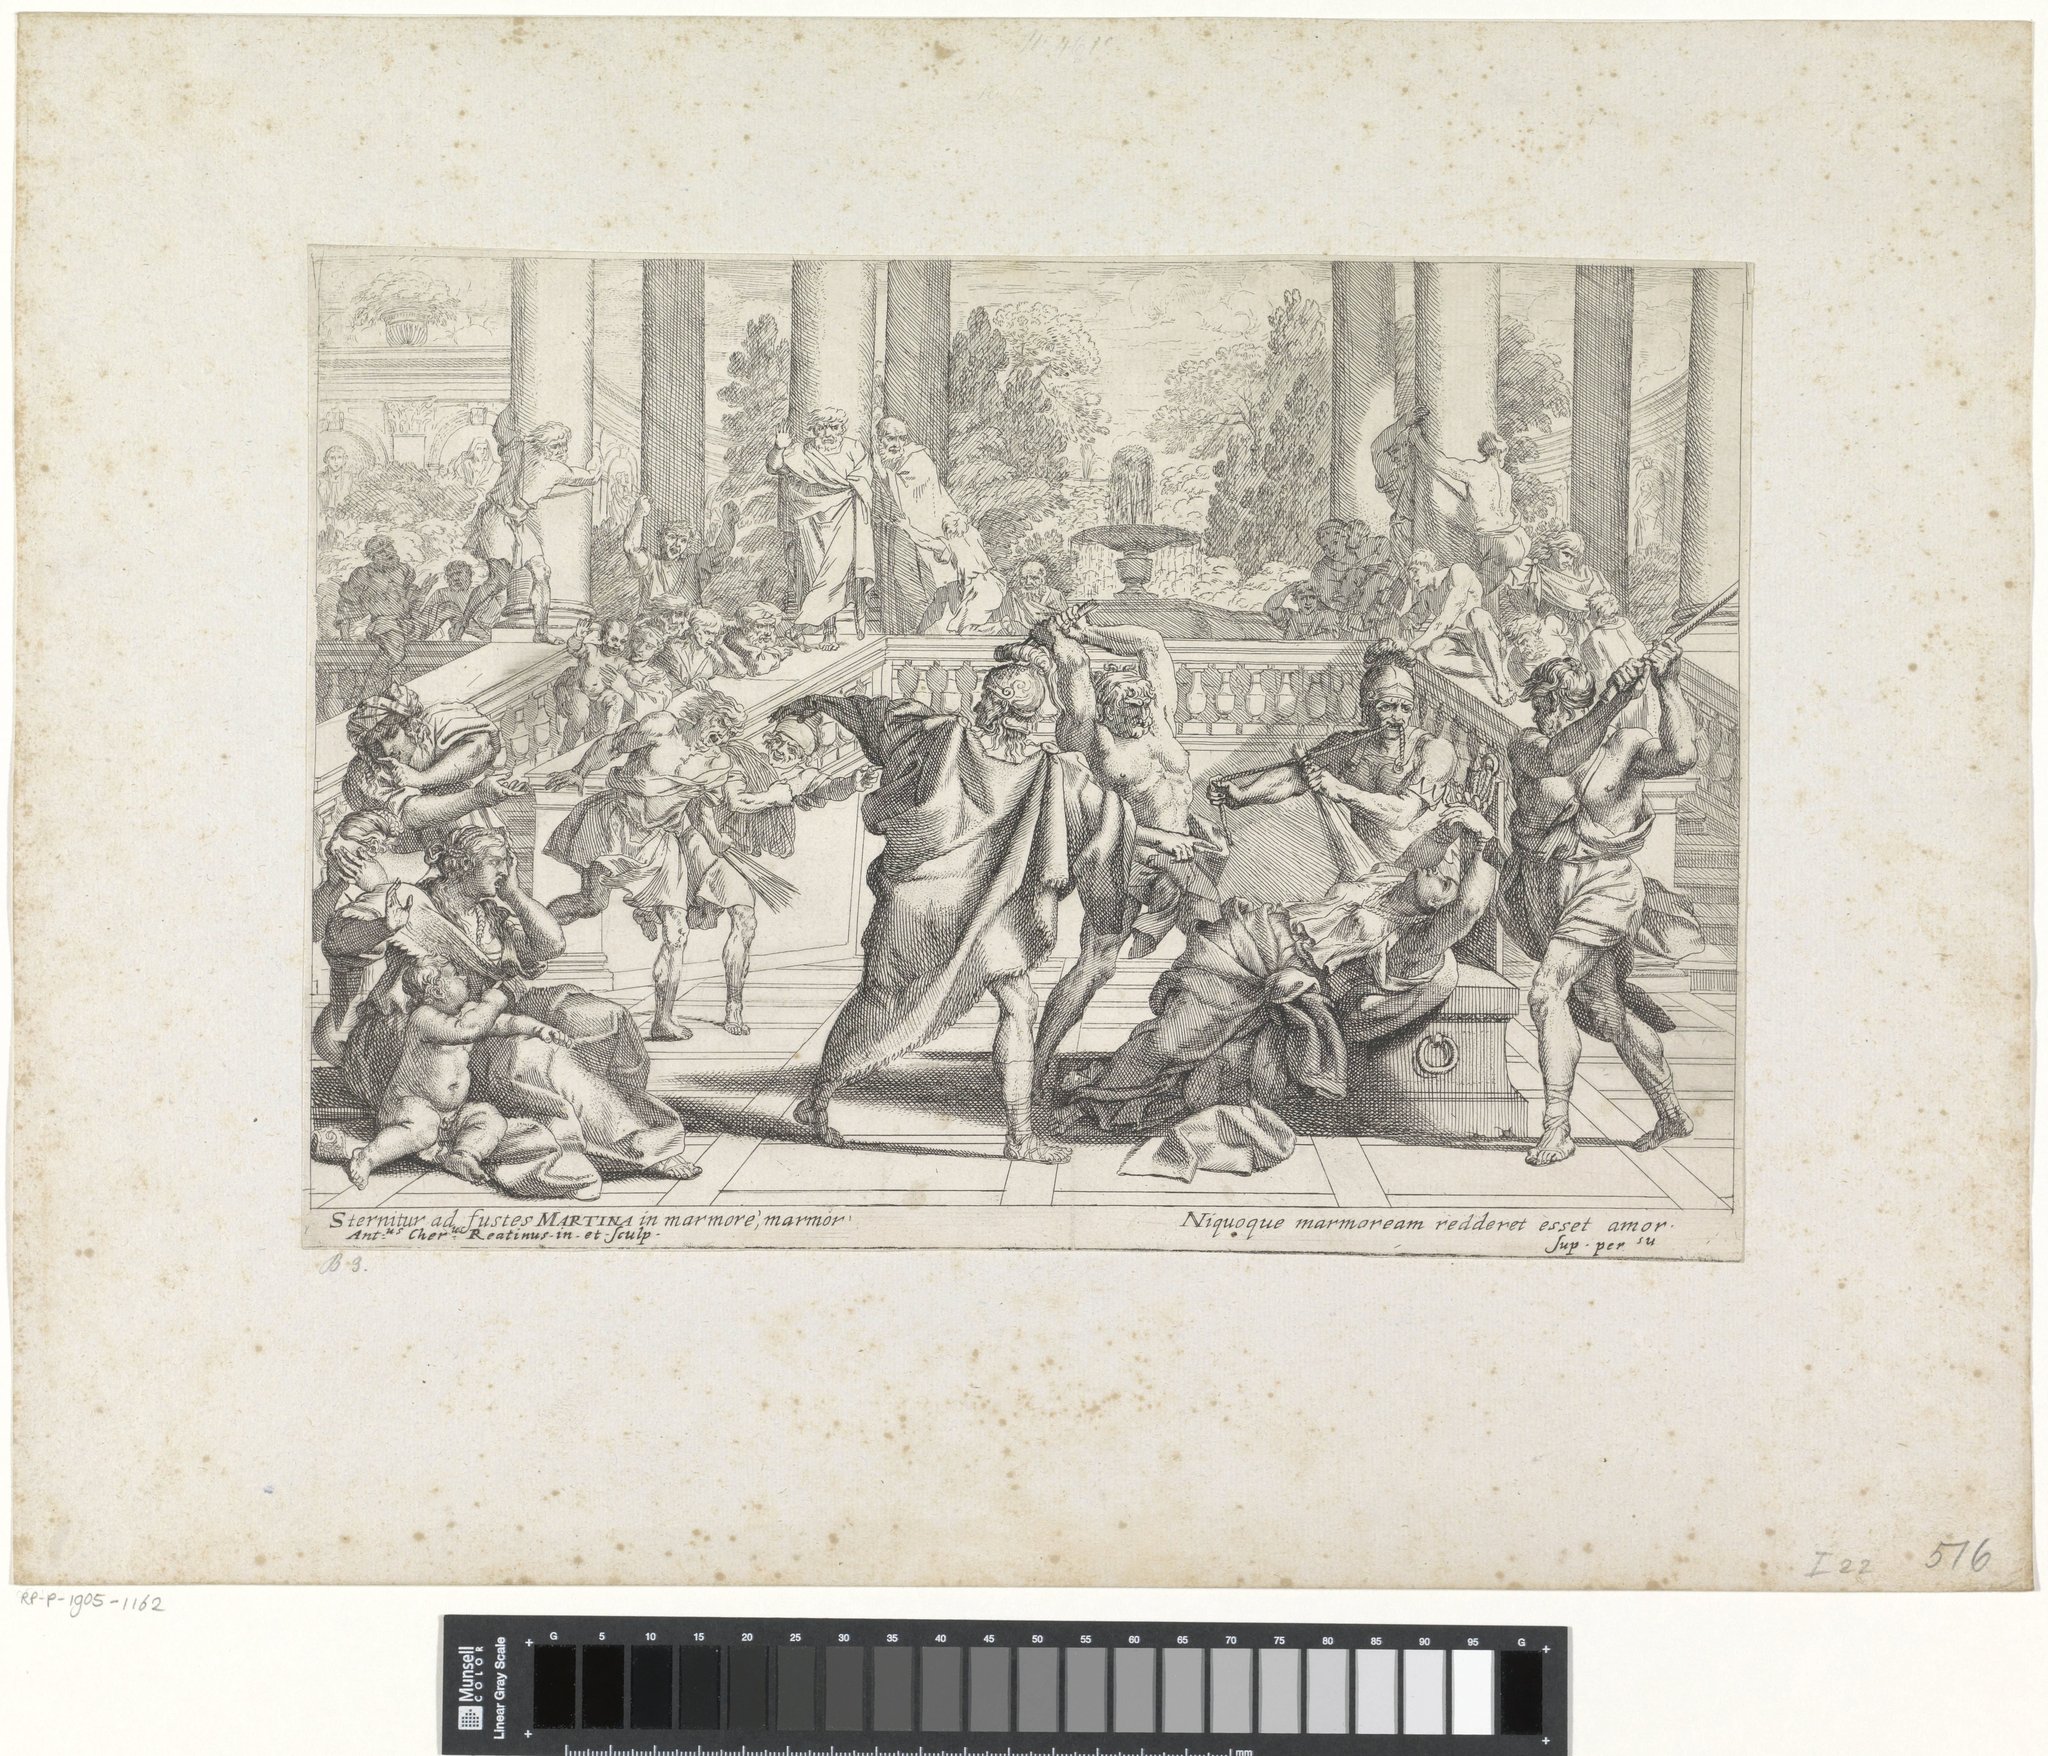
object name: print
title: Geseling van de heilige Martina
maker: antonio gherardi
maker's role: print maker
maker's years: 1644-1702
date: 1654-1702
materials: paper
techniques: etching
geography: italy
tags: female saints (martina of rome) - martyrdom, suffering, misfortune, death of female saint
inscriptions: collector's mark: Lugt 2228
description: De heilige Martina ligt vastgebonden op een blok. Ze wordt gegeseld door mannen met zwepen. Mannen, vrouwen en kinderen kijken toe vanaf trappen op de achtergrond.